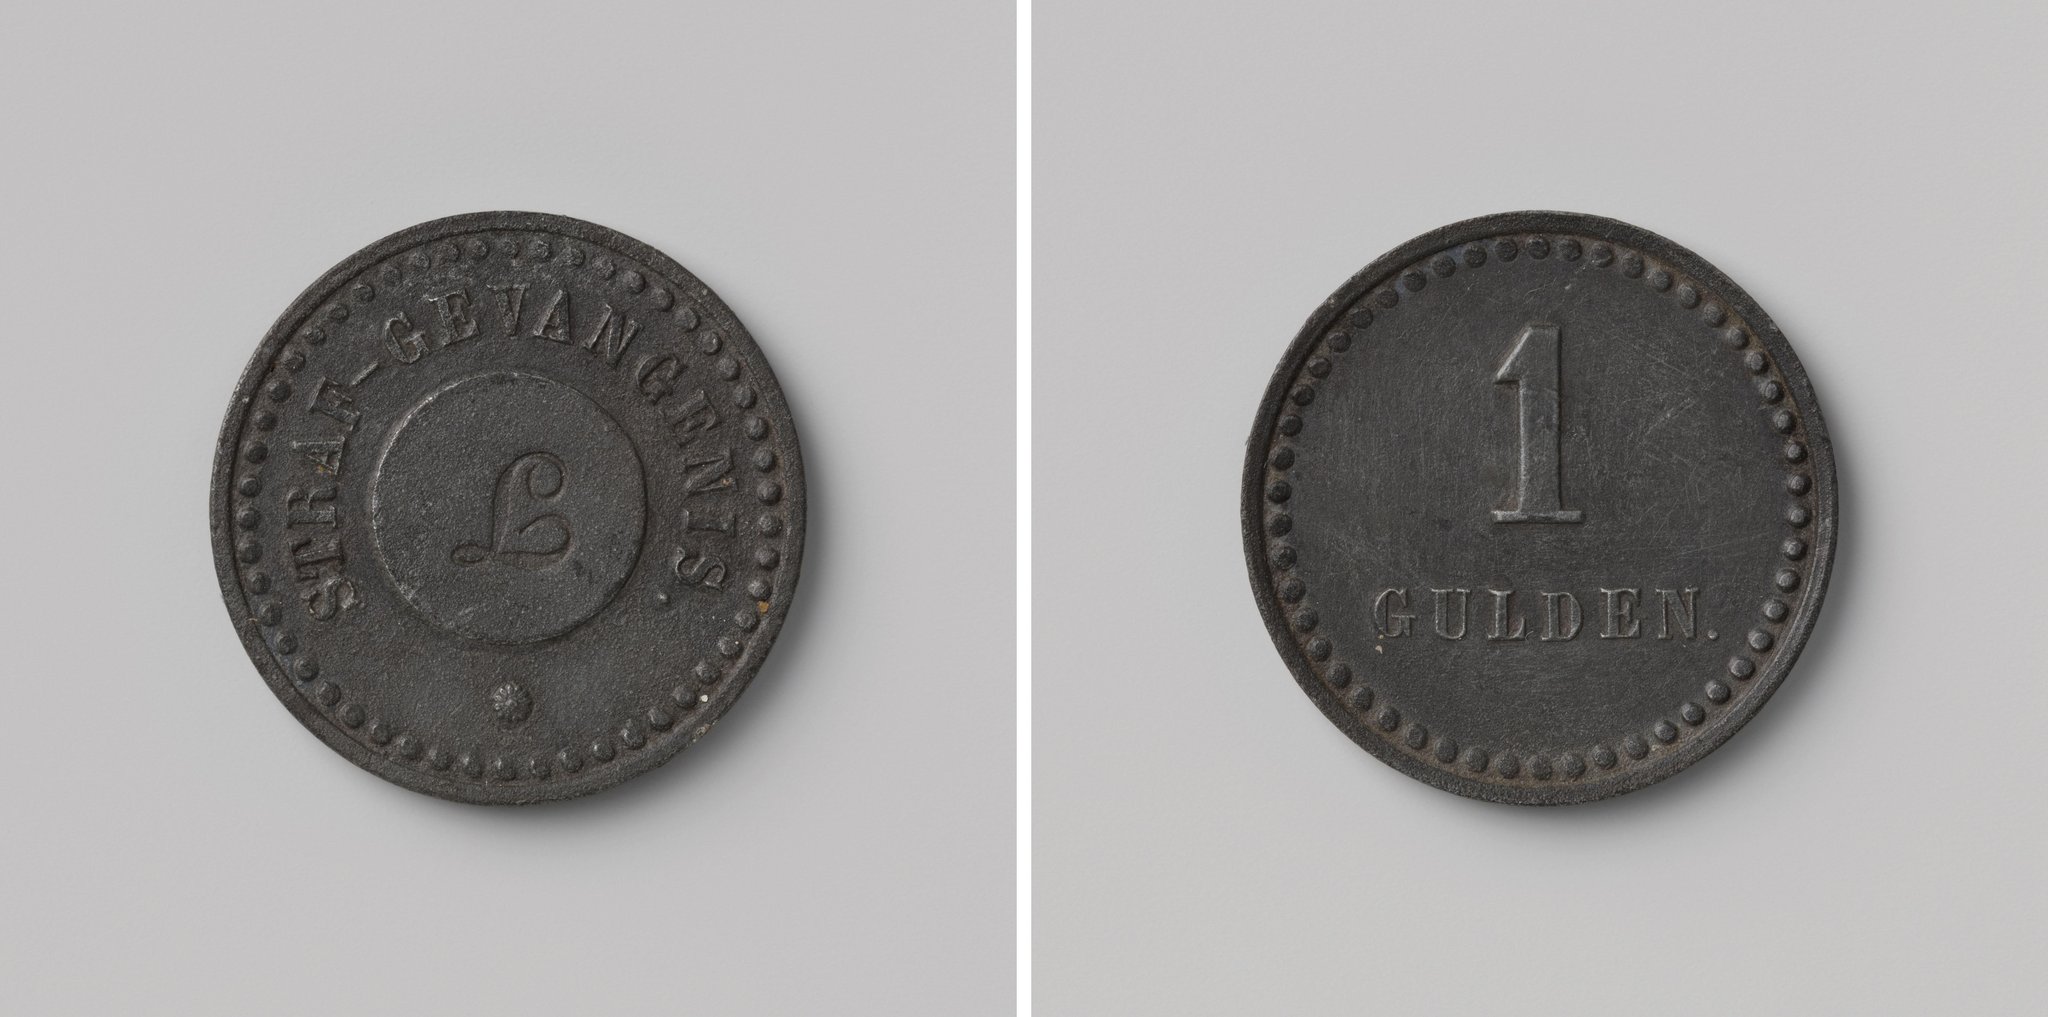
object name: gulden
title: Strafgevangenis te Leeuwarden, huismunt ter waarde van een gulden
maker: Anonymous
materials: zinc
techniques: striking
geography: utrecht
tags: leeuwarden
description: Zinken betaalpenning. Voorzijde: letter L binnen omschrift. Keerzijde: waardeaanduiding